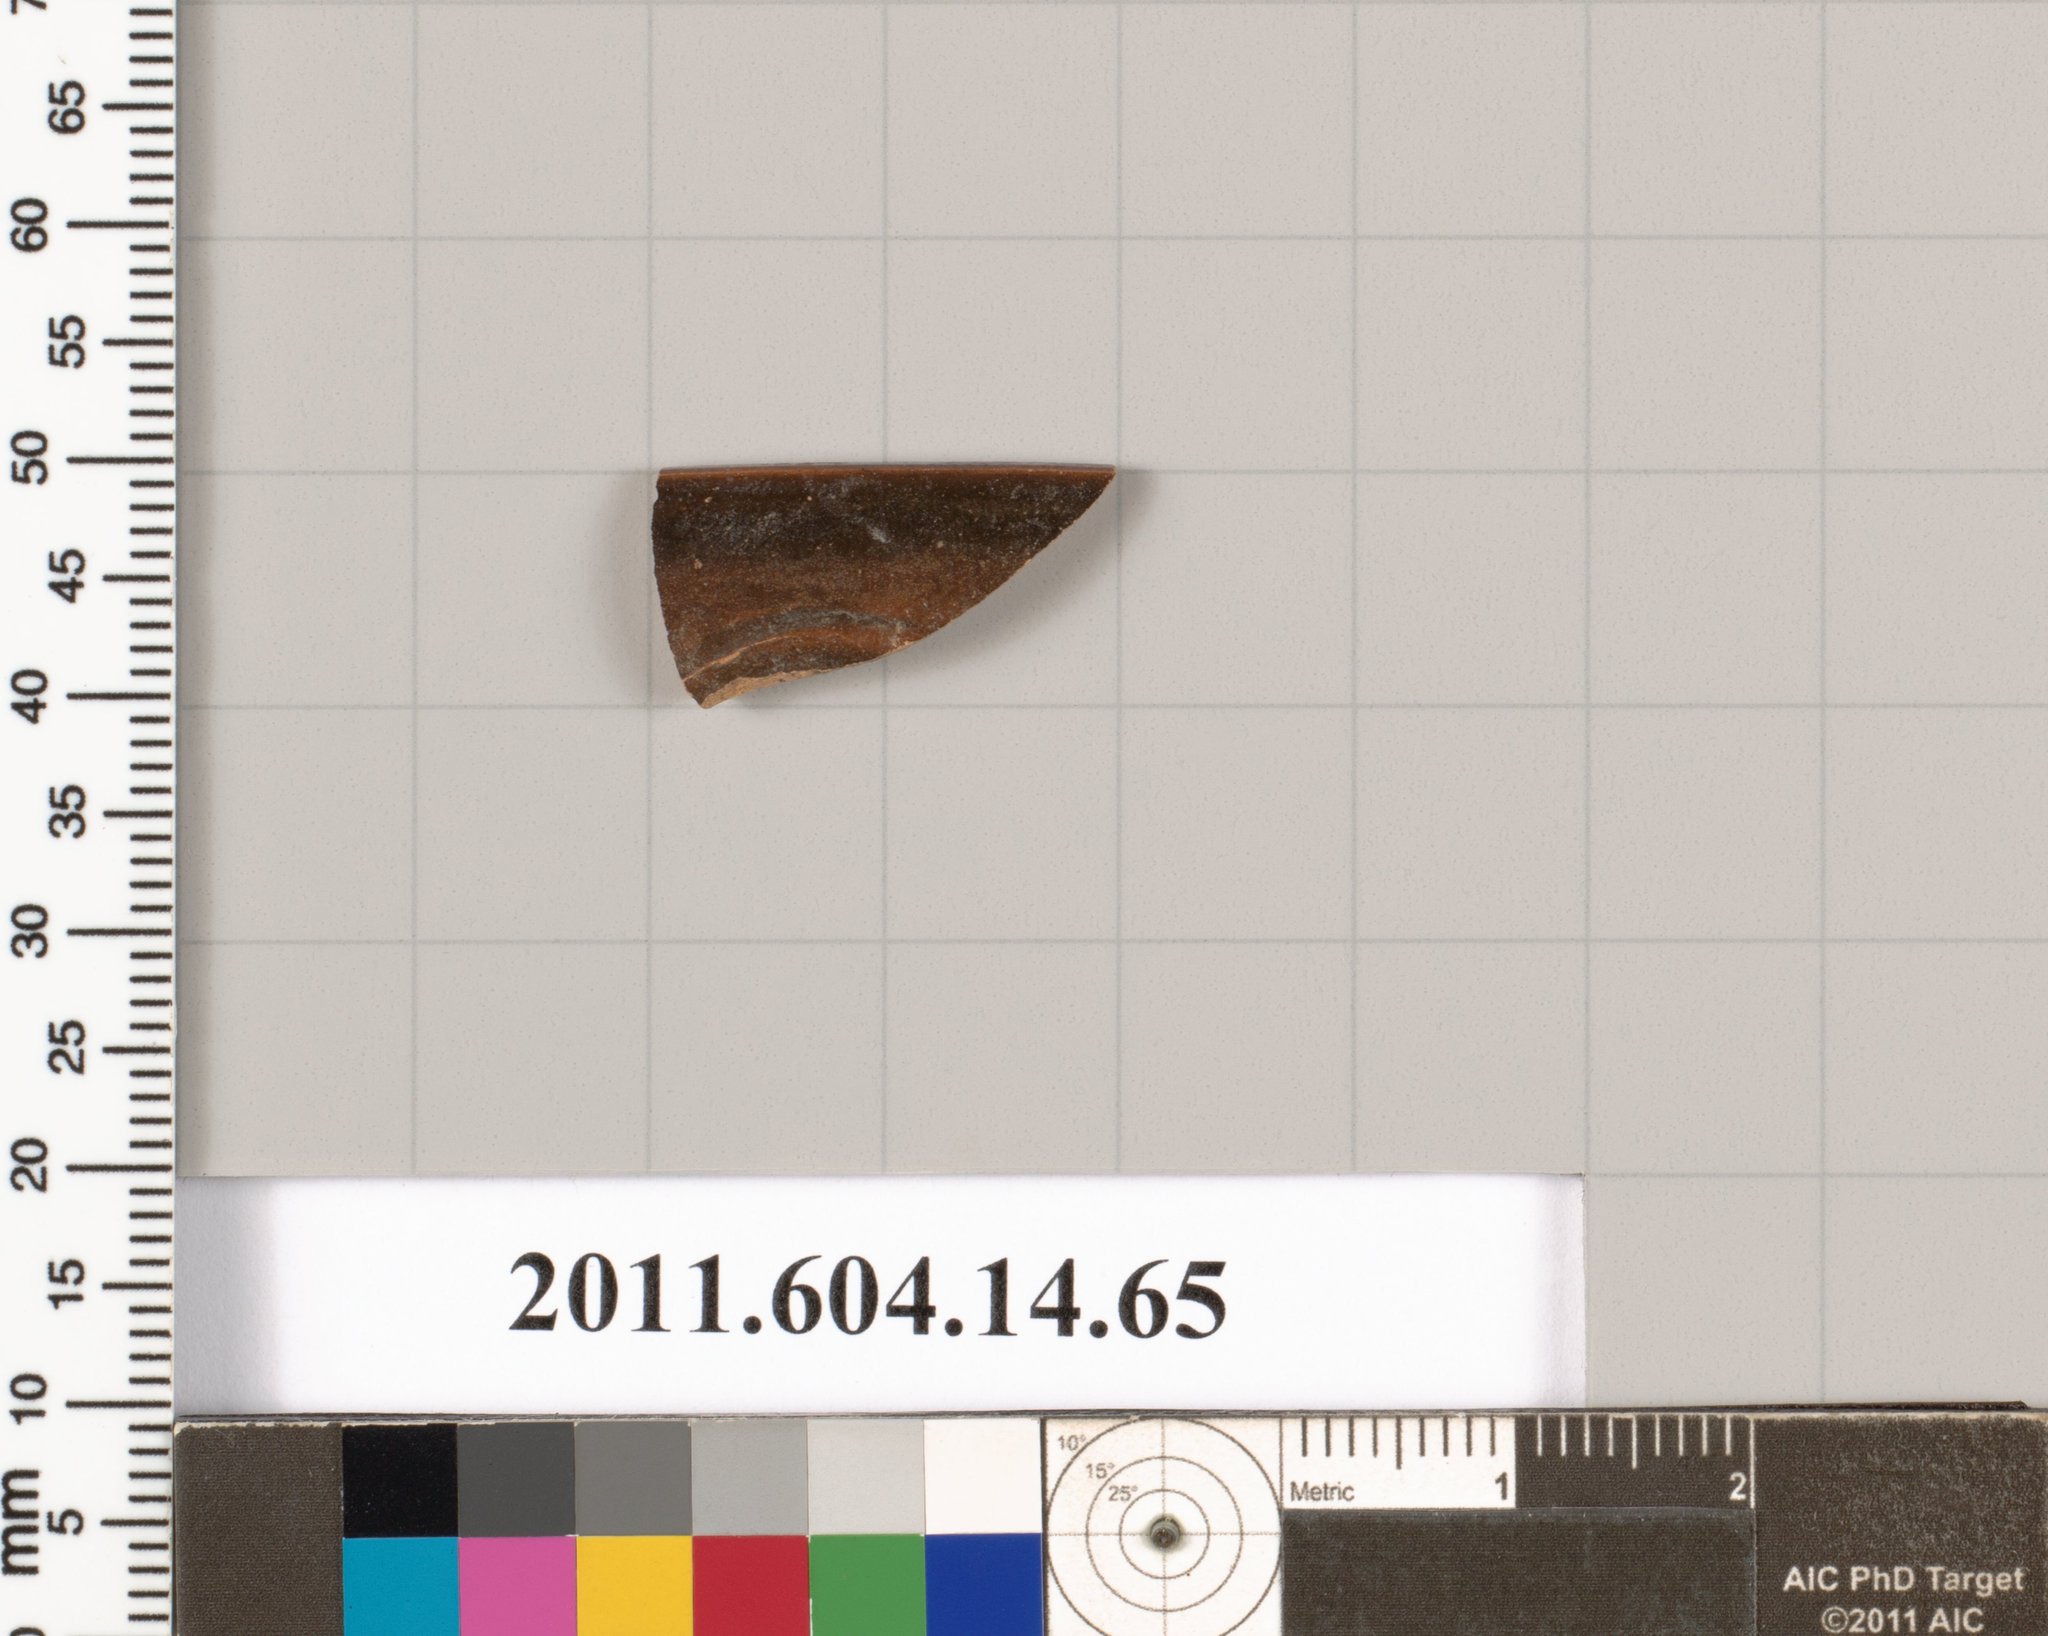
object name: kylix fragment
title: Terracotta rim fragment of a kylix (drinking cup)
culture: unknown fabric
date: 600-401 BCE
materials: terracotta